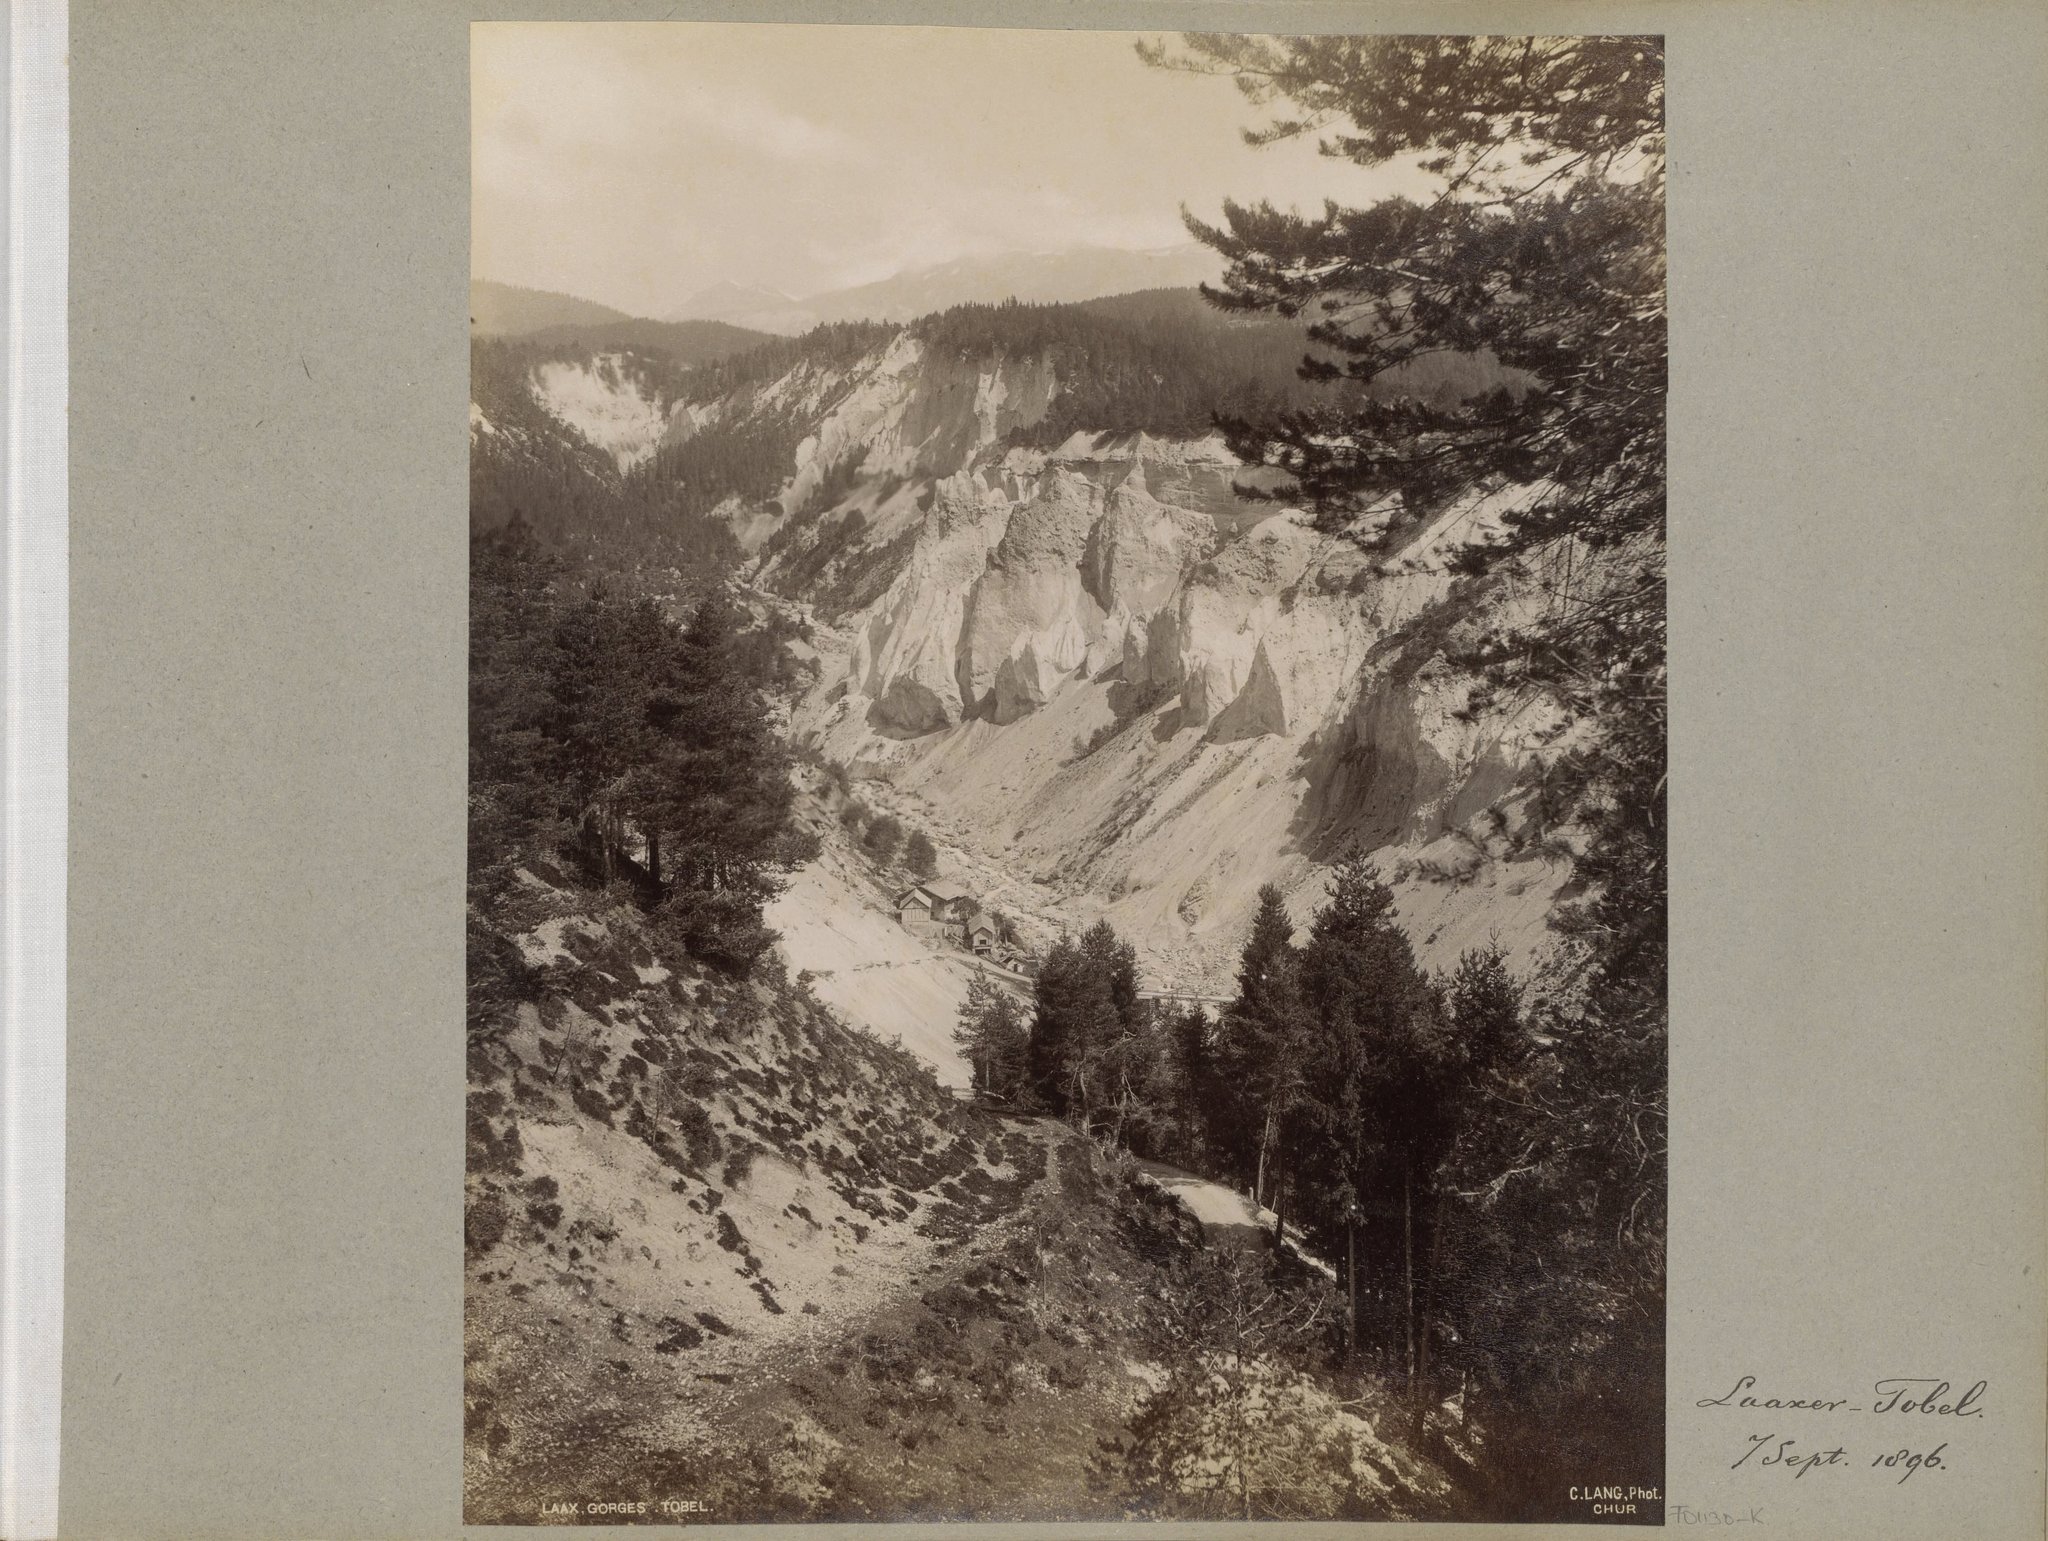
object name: album leaf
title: Laax, Gorges. Tobel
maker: carl lang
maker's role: fotograaf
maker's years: 1830-1906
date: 1880-1896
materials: paper, photographic support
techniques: albumen print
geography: laax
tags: ravine, chasm, abyss, canyon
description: Onderdeel van Reisalbum met foto's van bezienswaardigheden in Frankrijk, Spanje, Italië, Duitsland, Zwitserland en Oostenrijk.